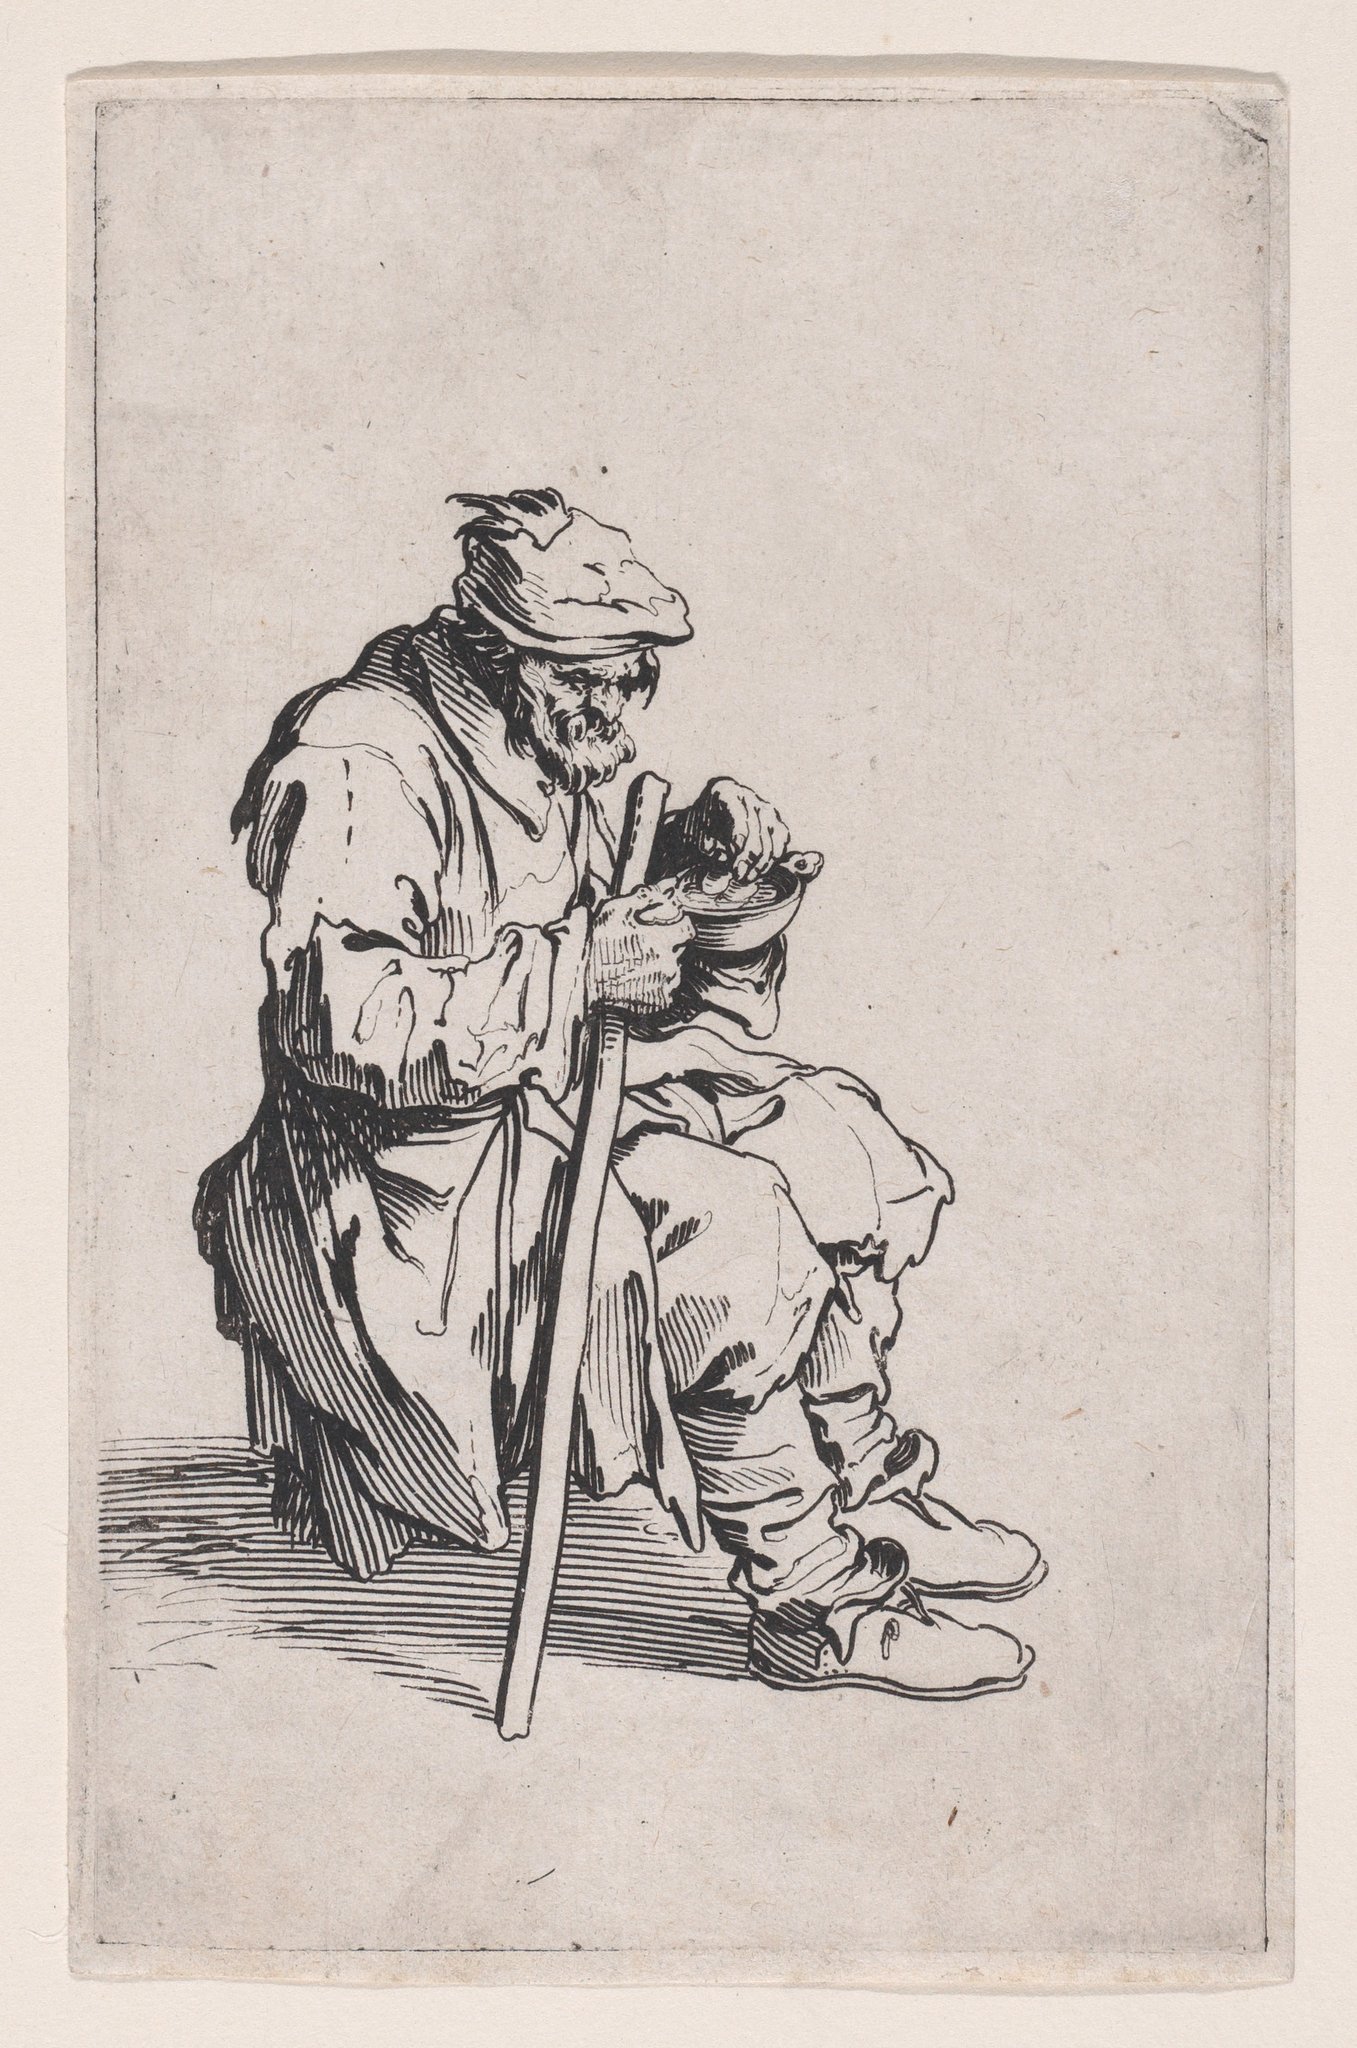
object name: print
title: Le Gueux Assis et Mangeant (The Beggar Sitting and Eating), from "Les Gueux suite appelée aussi Les Mendiants, Les Baroni, ou Les Barons" (The Beggars, also called the Barons)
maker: jacques callot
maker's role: artist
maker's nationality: french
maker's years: 1592-1635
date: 1623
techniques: etching